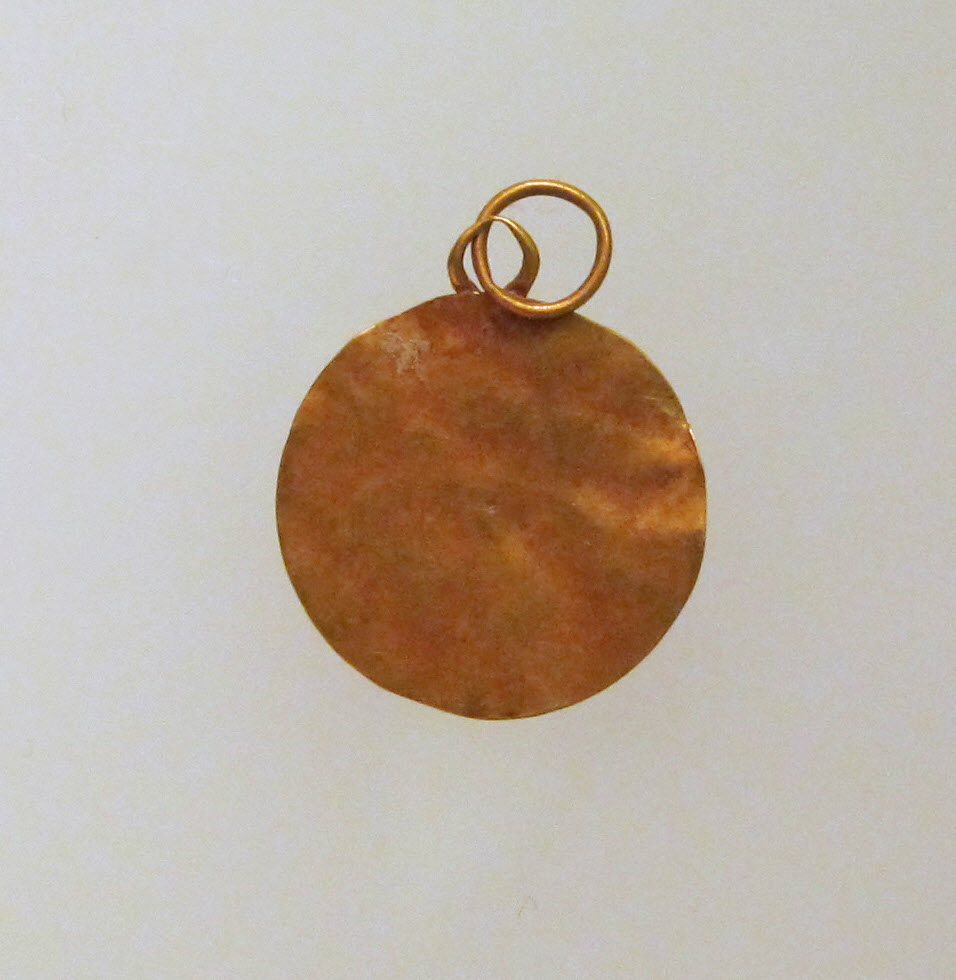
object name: pendant disk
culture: cypriot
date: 3900 BCE-100 CE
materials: gold